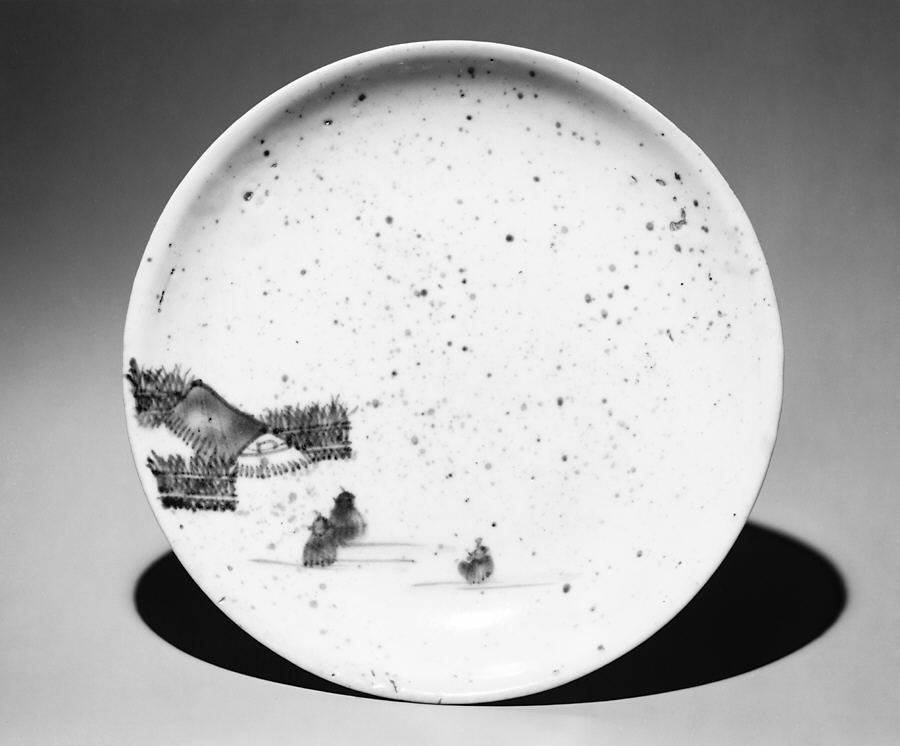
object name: dish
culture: japanese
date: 1615-1868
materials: porcelain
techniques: underglaze